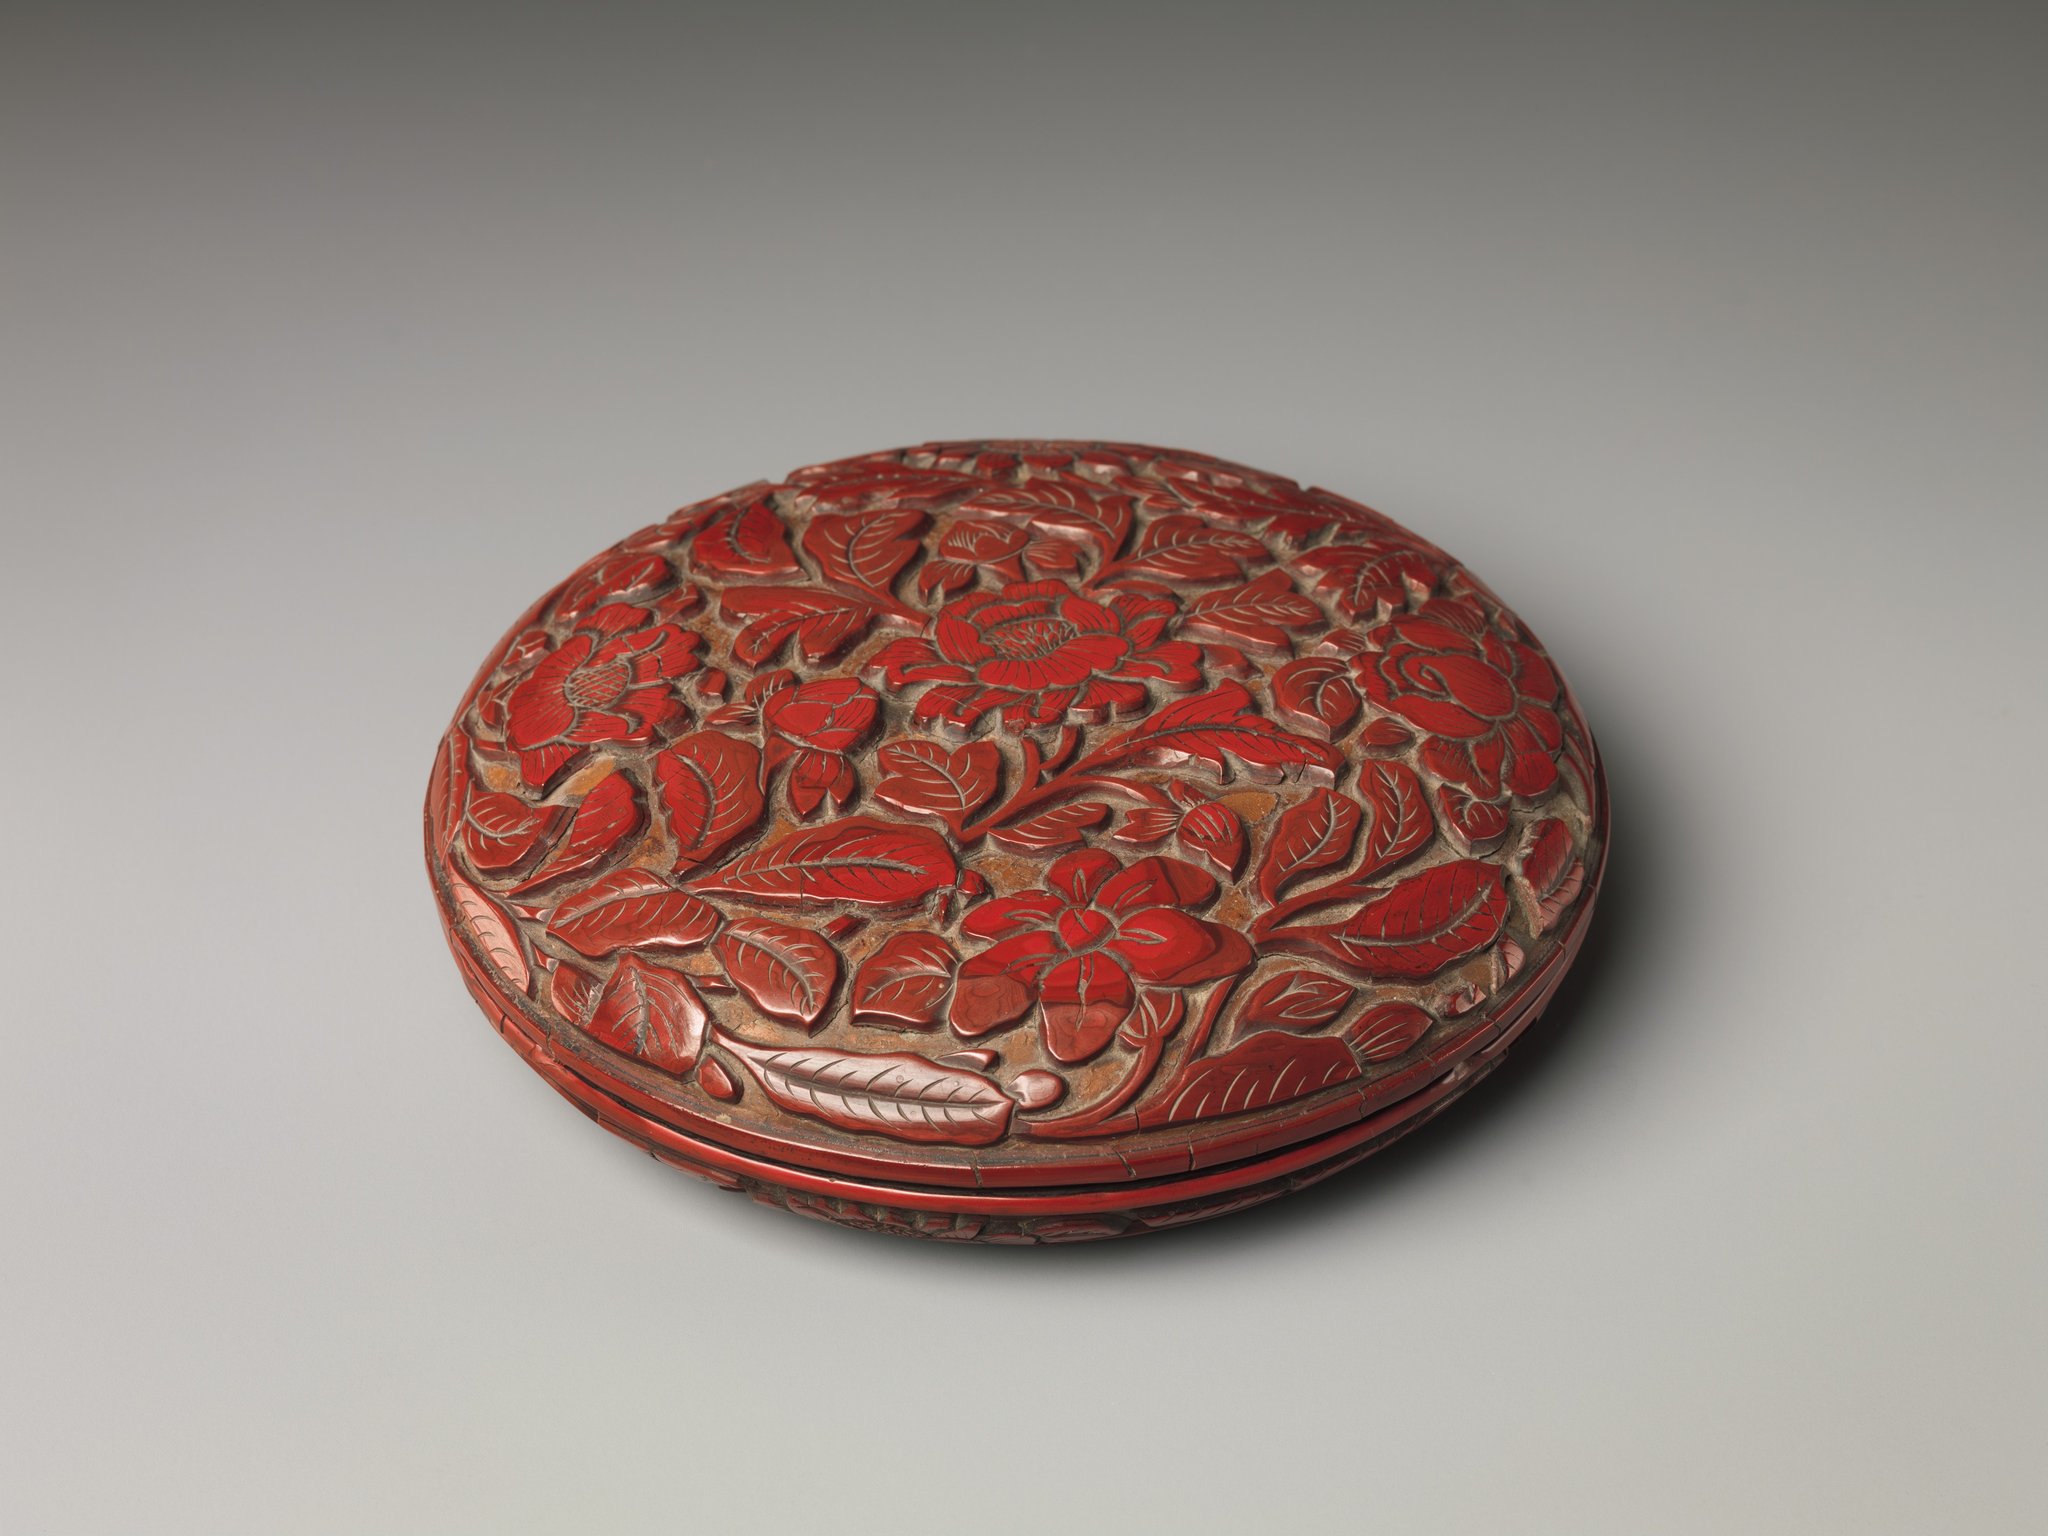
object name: box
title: Incense Box (Kōgō) with Camellias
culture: chinese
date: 1201-1300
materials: lacquer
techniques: carving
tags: flowers,leaves